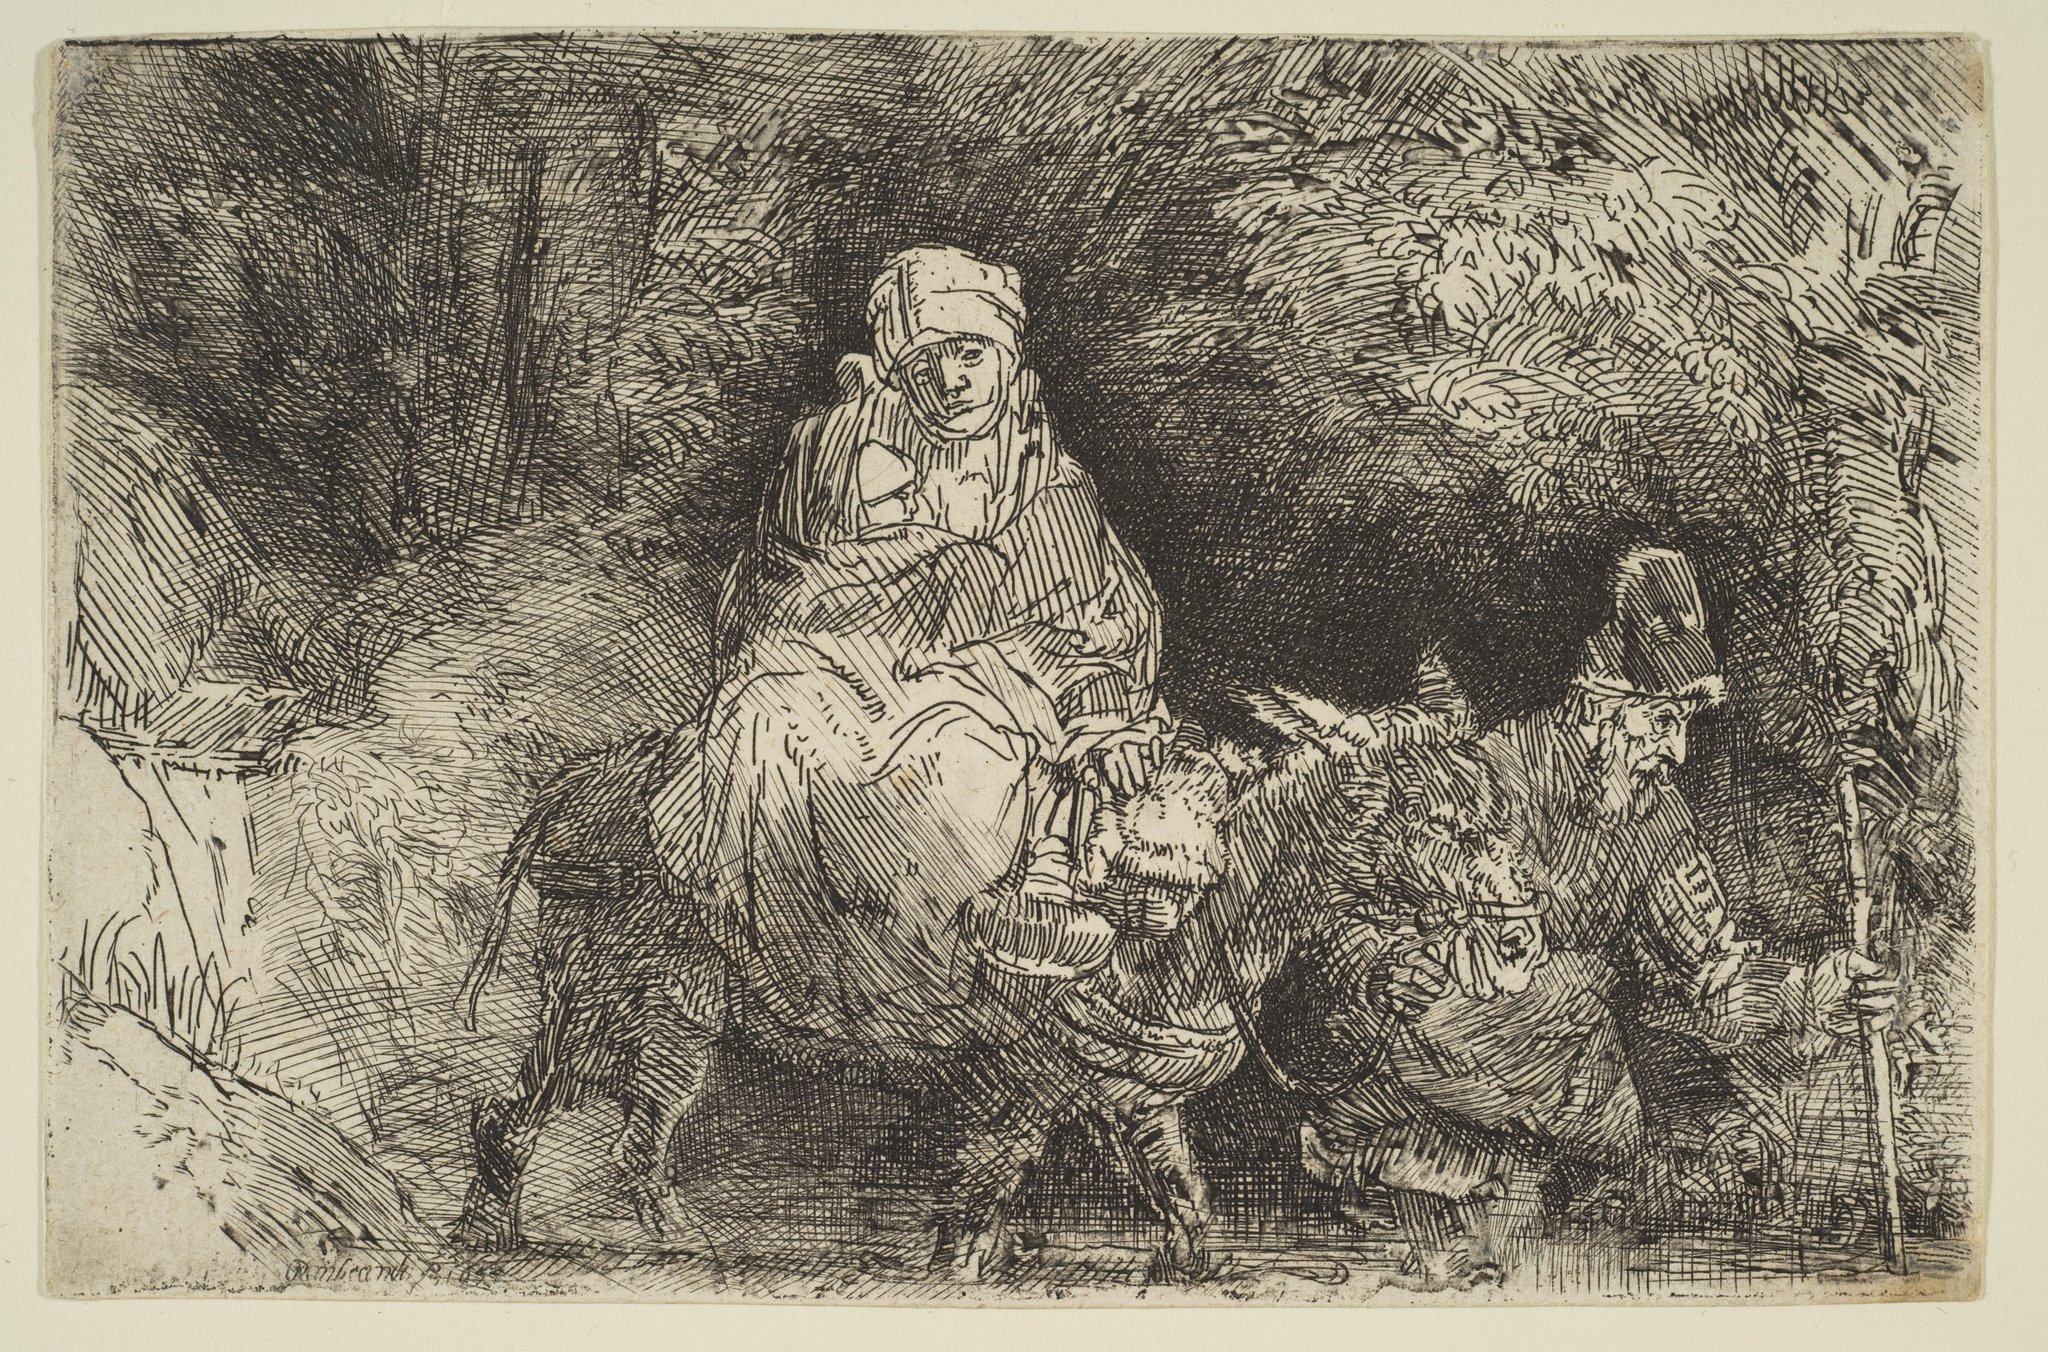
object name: print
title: The Flight into Egypt: Crossing a Brook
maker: rembrandt van rijn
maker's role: artist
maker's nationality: dutch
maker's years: 1606-1669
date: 1654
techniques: drypoint, engraving, etching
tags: men,women,donkeys,flight into egypt